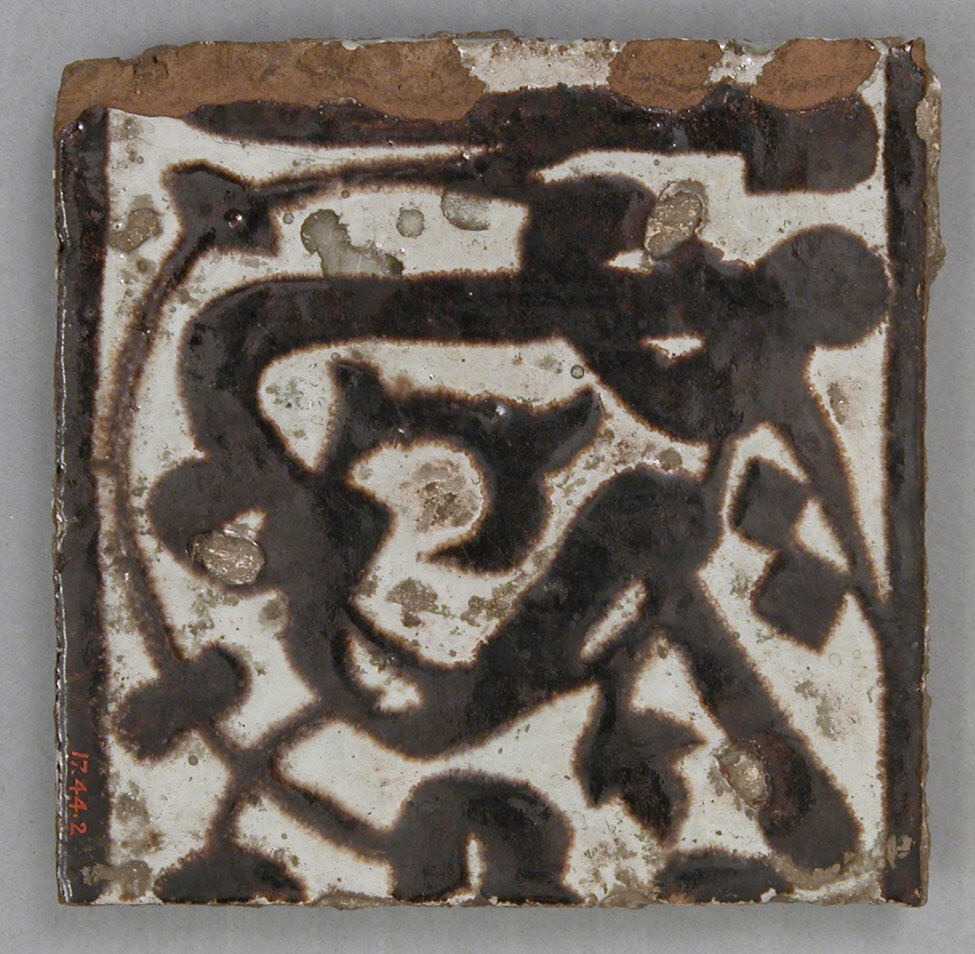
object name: tile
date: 1301-1400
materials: stonepaste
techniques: glazing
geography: morocco